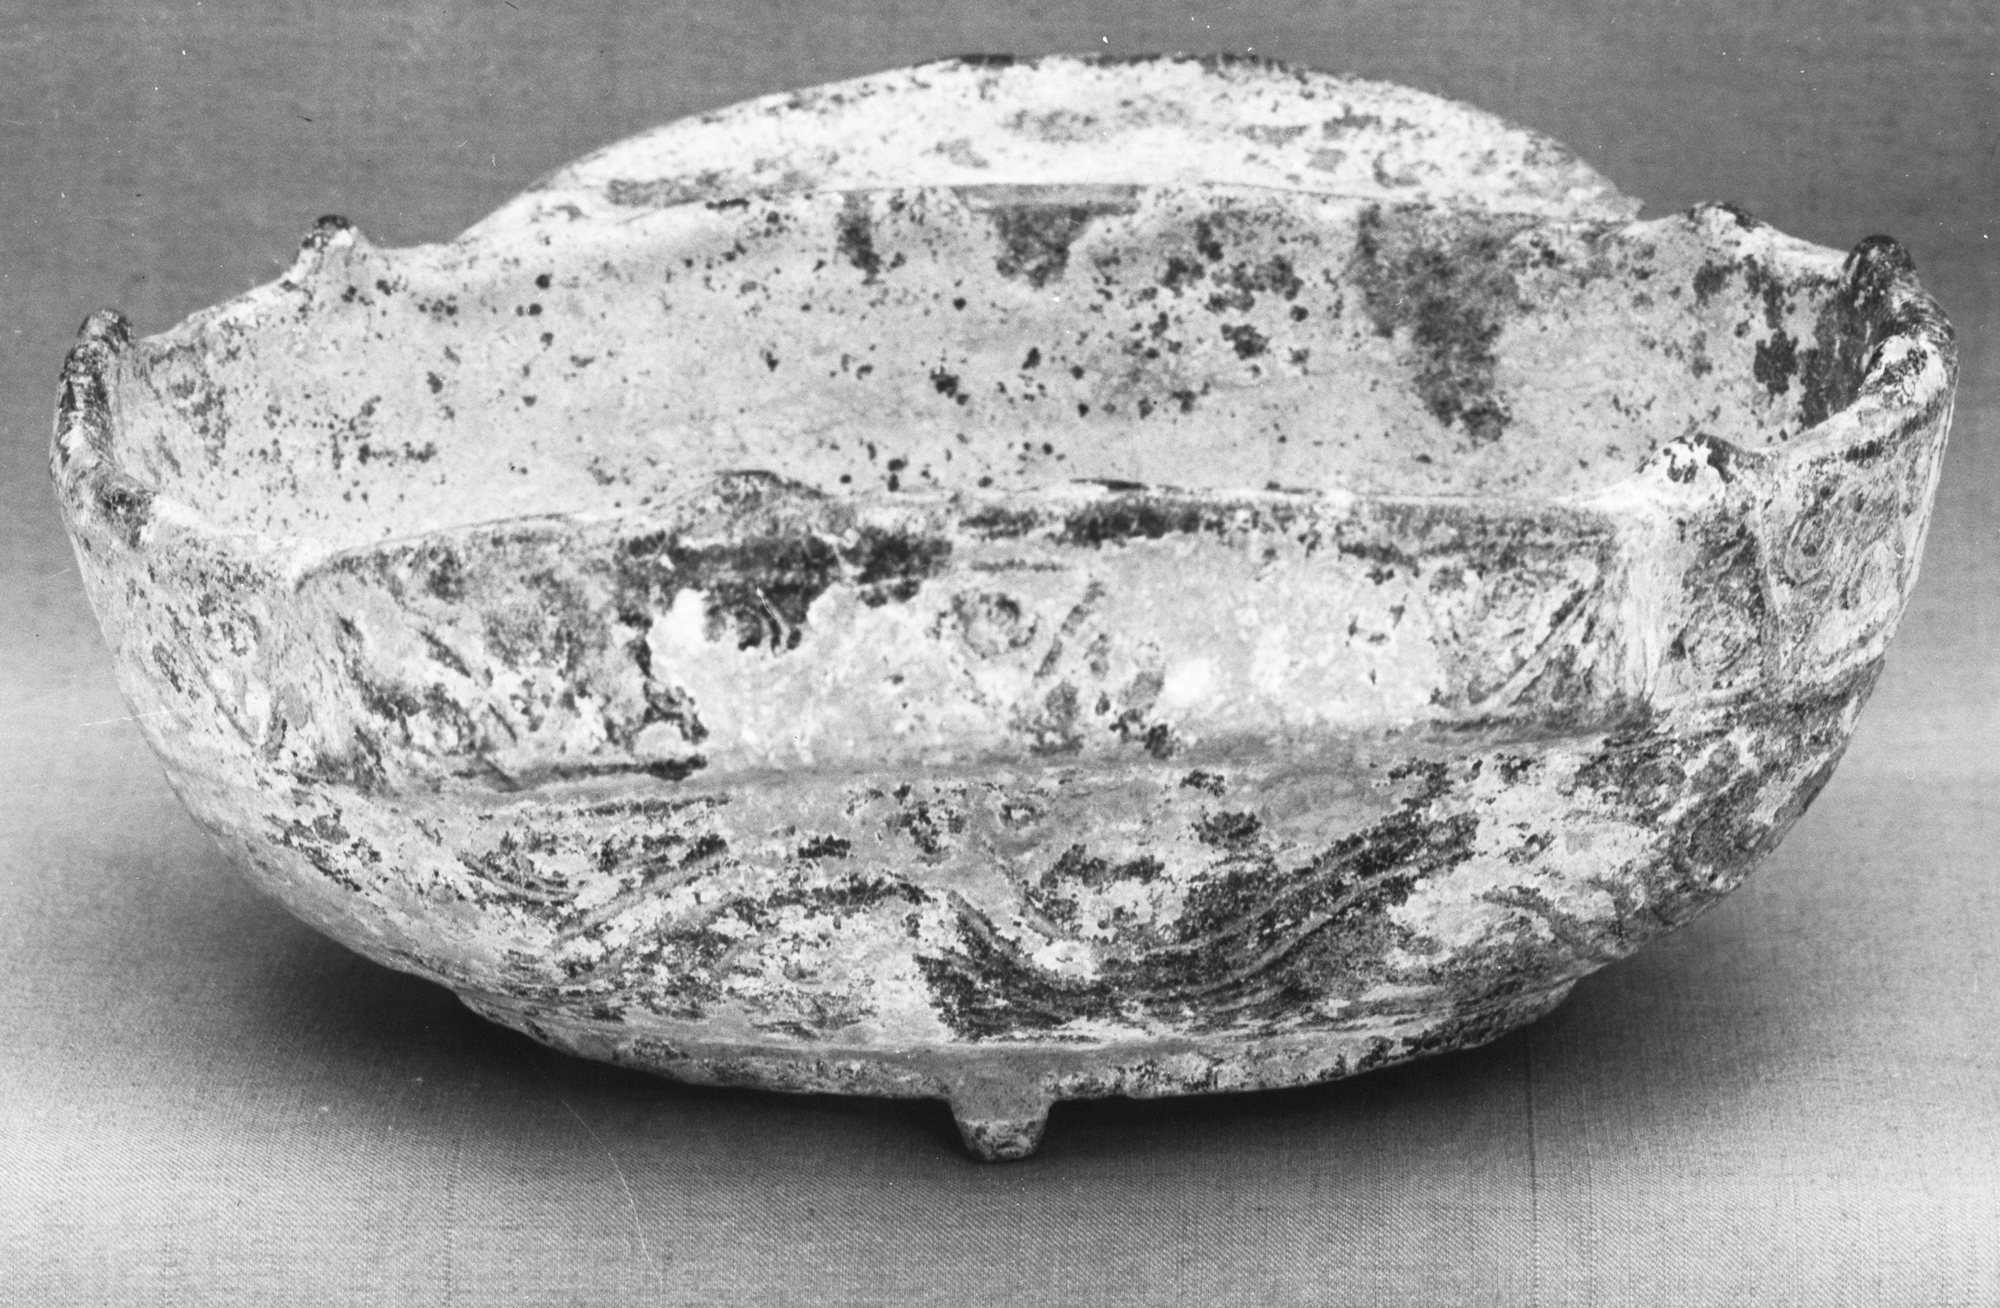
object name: bowl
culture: chinese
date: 206 BCE-220 CE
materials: earthenware